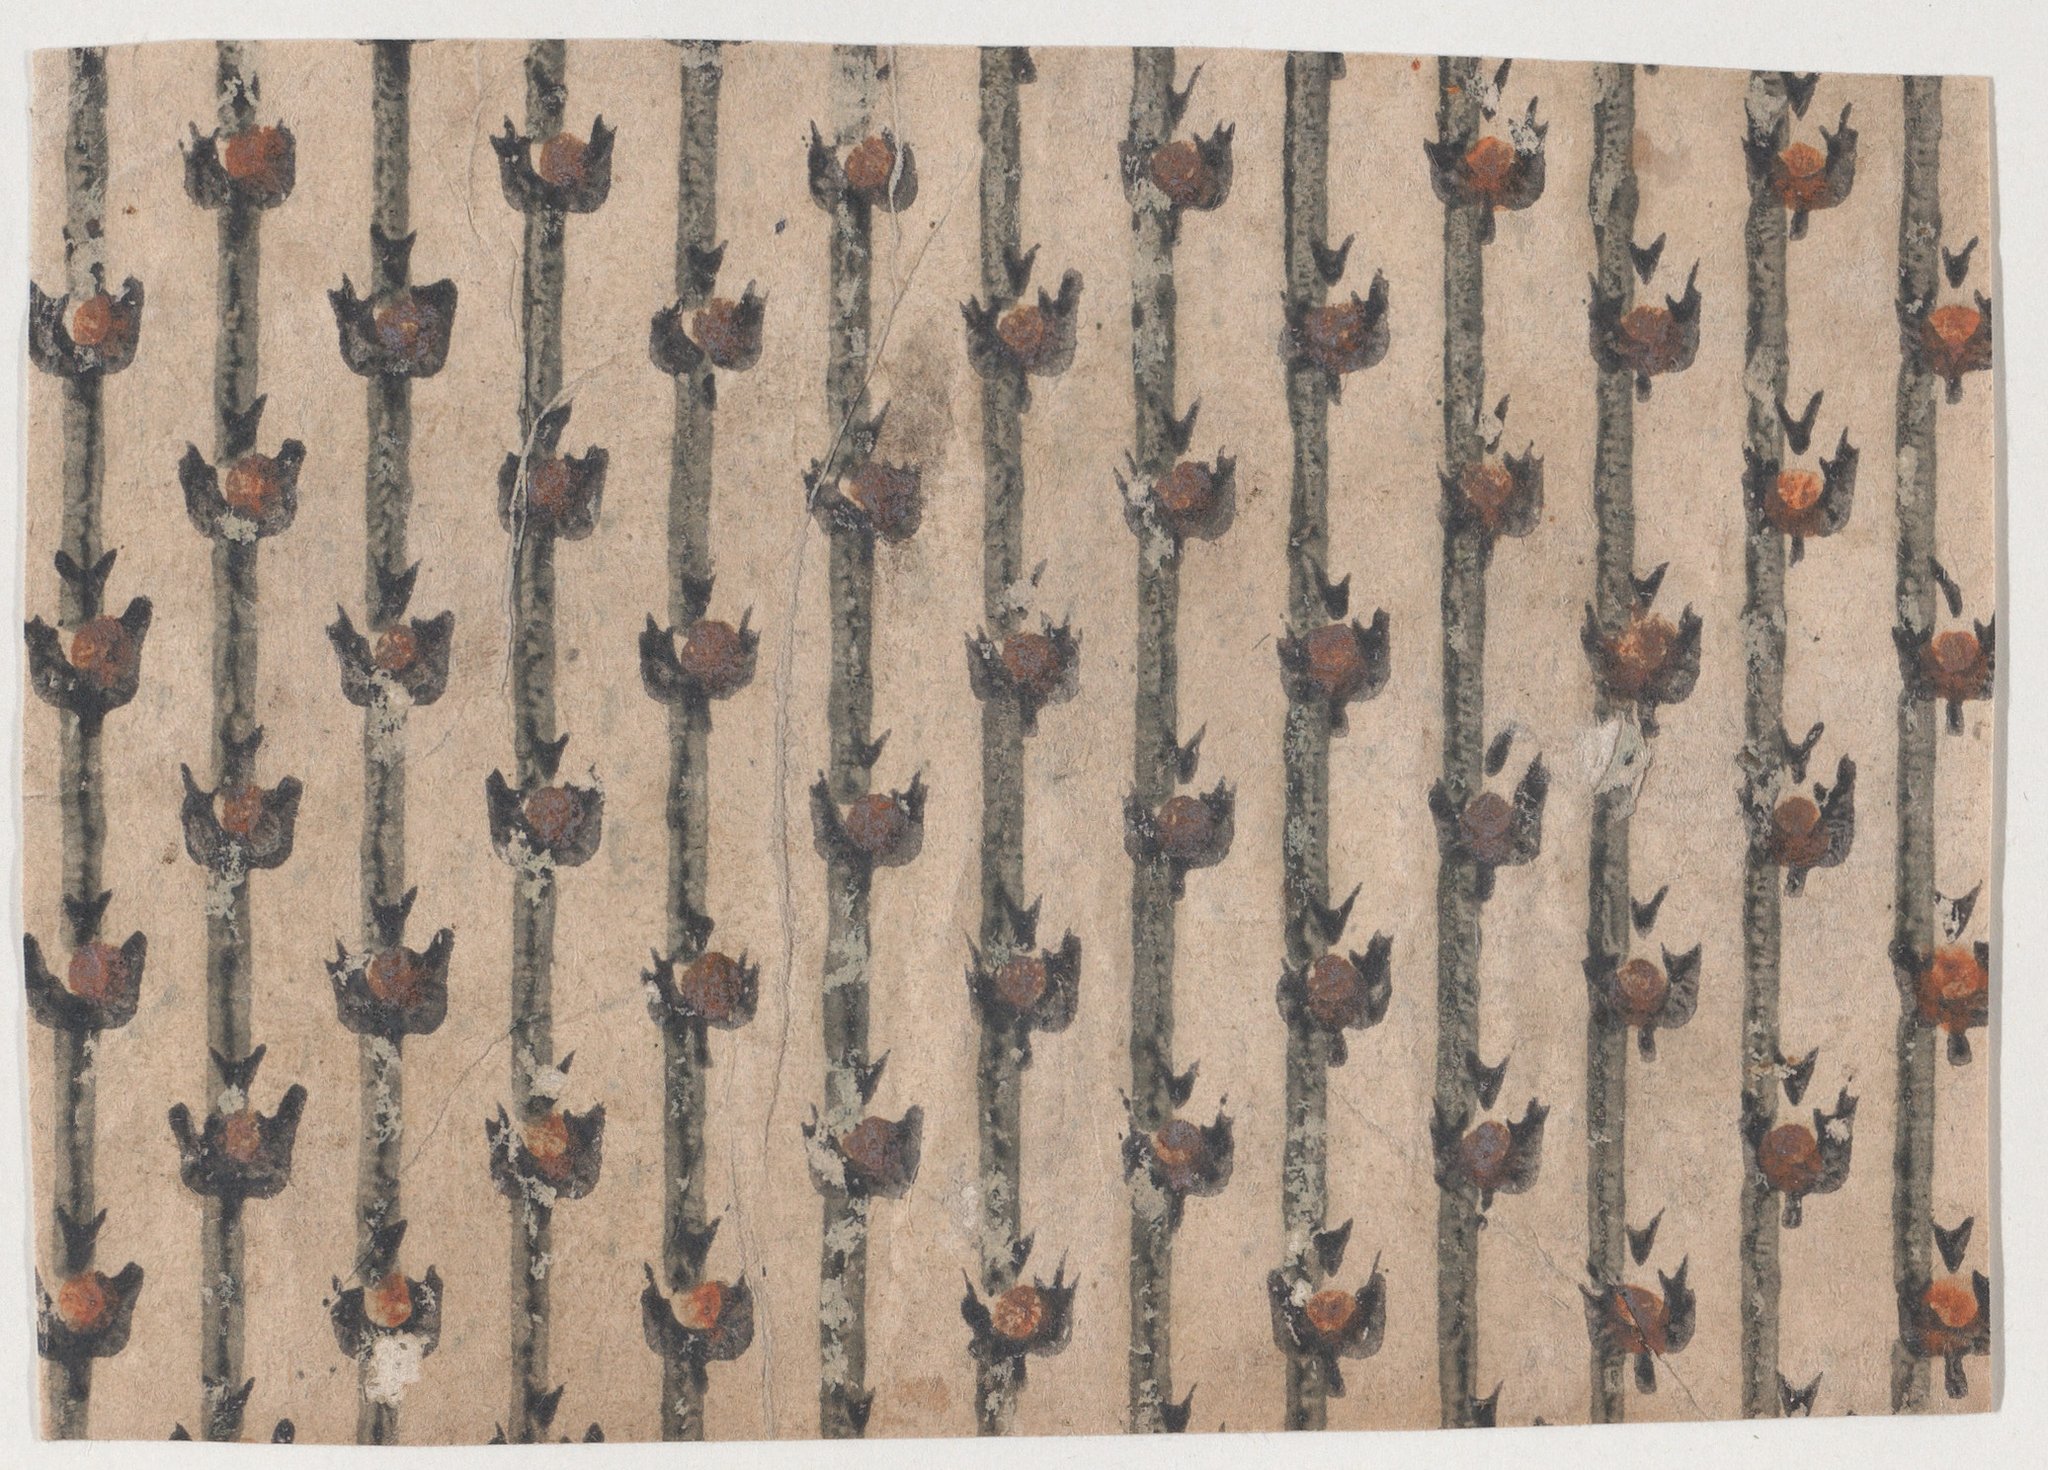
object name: print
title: Sheet with abstract and stripe pattern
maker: Anonymous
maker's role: artist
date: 1801-1900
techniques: relief print